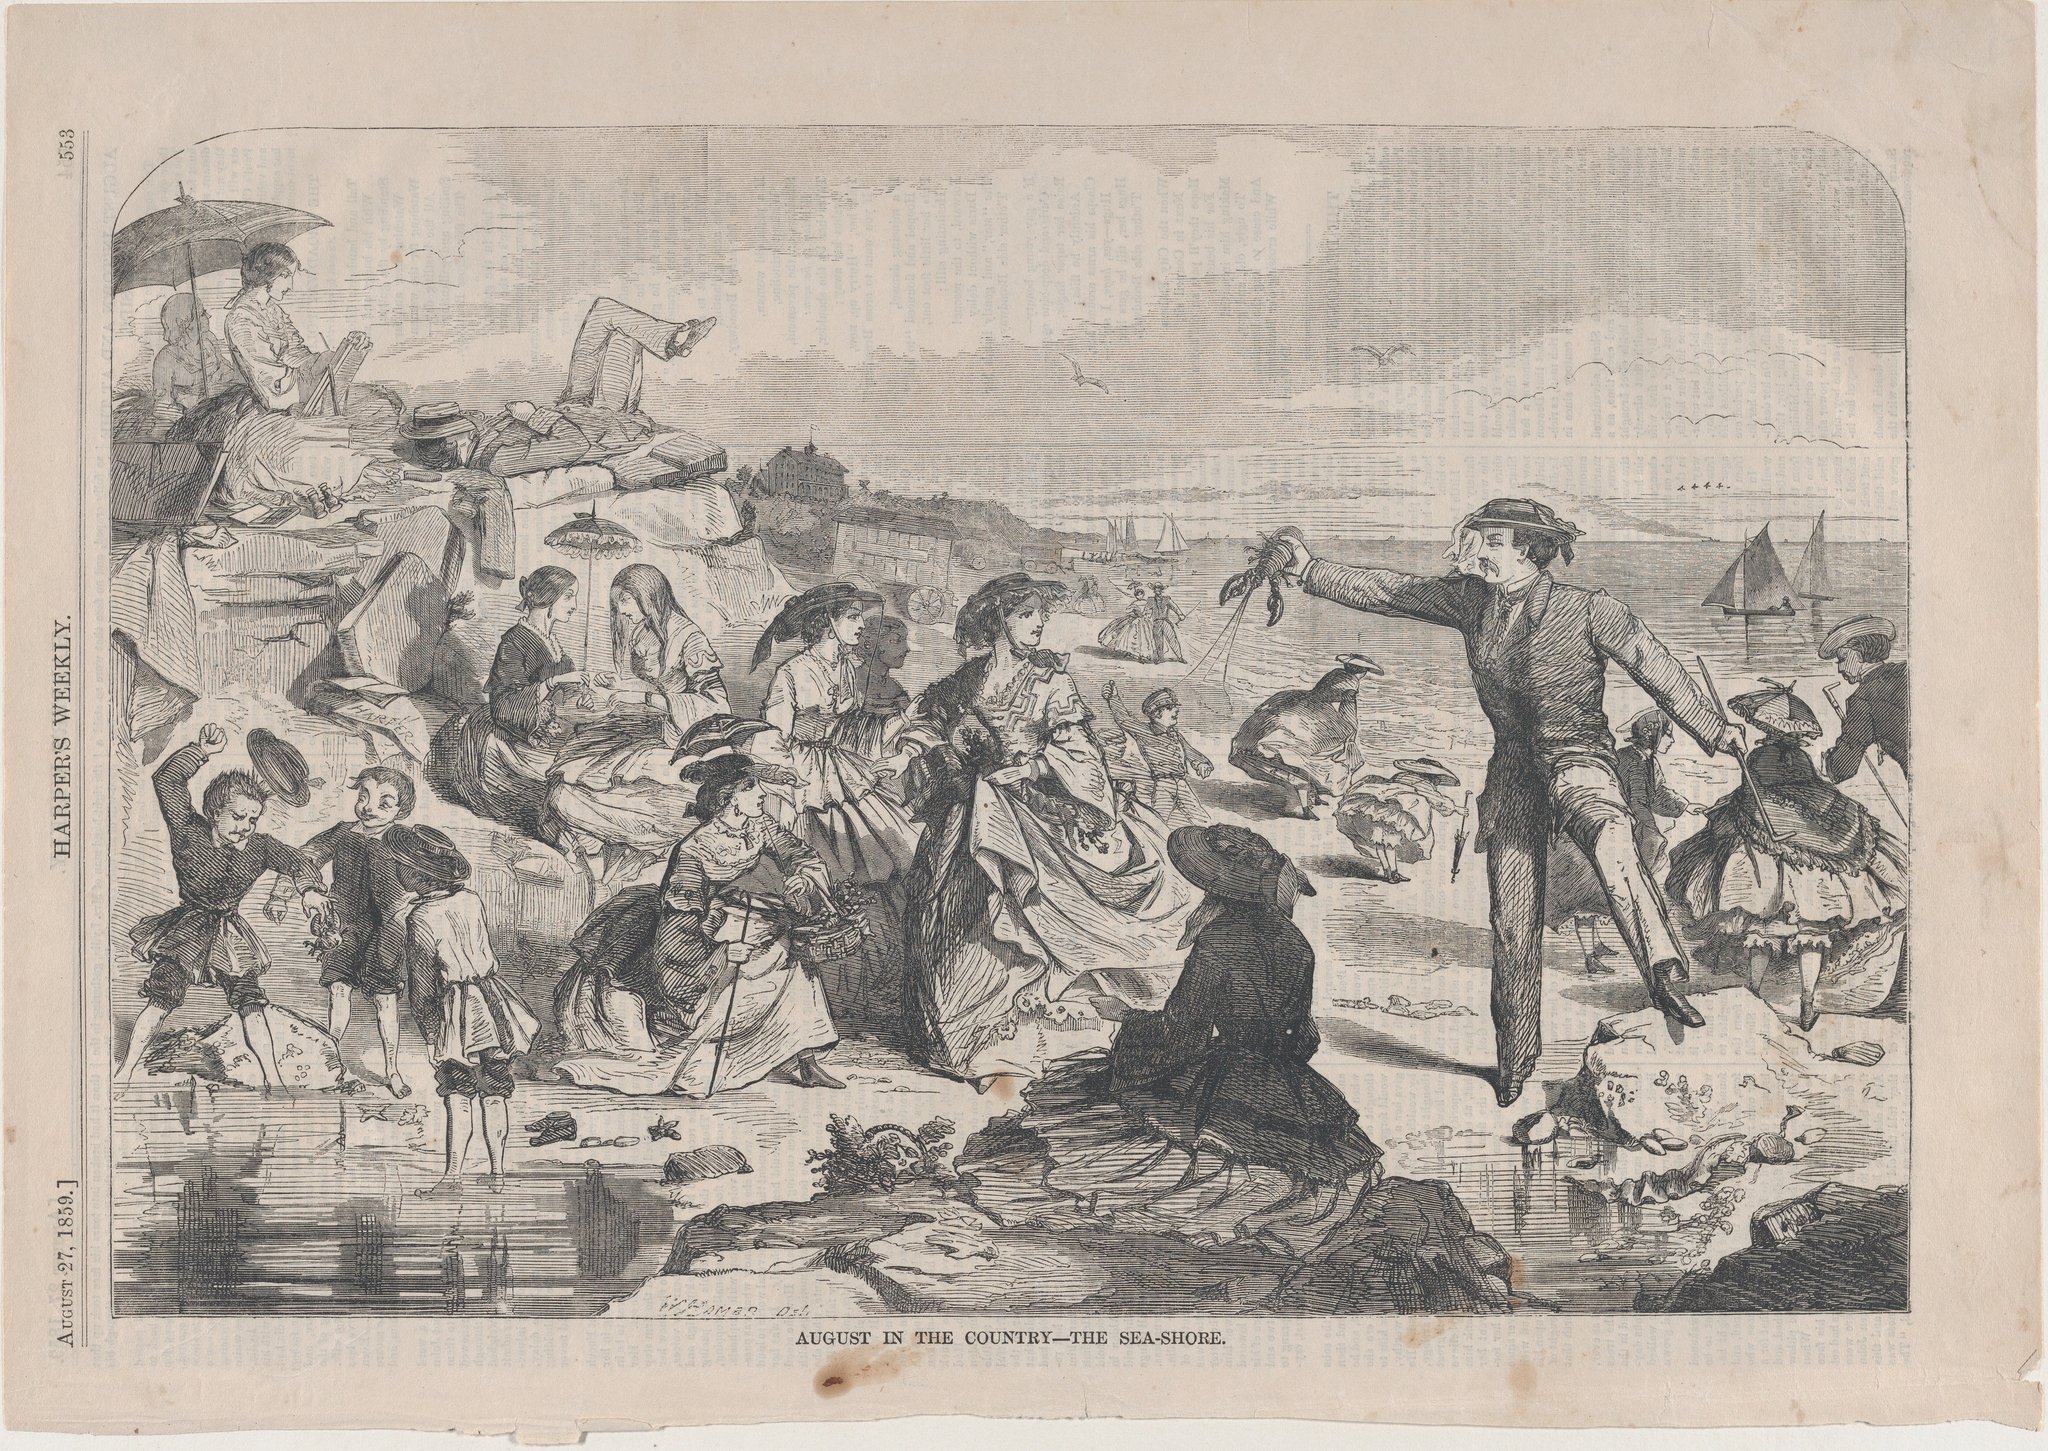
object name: print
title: August in the Country – The Sea-Shore (from "Harper's Weekly," Vol. III)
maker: winslow homer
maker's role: artist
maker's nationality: american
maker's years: 1836-1910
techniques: engraving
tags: boys,men,women,crabs,beaches